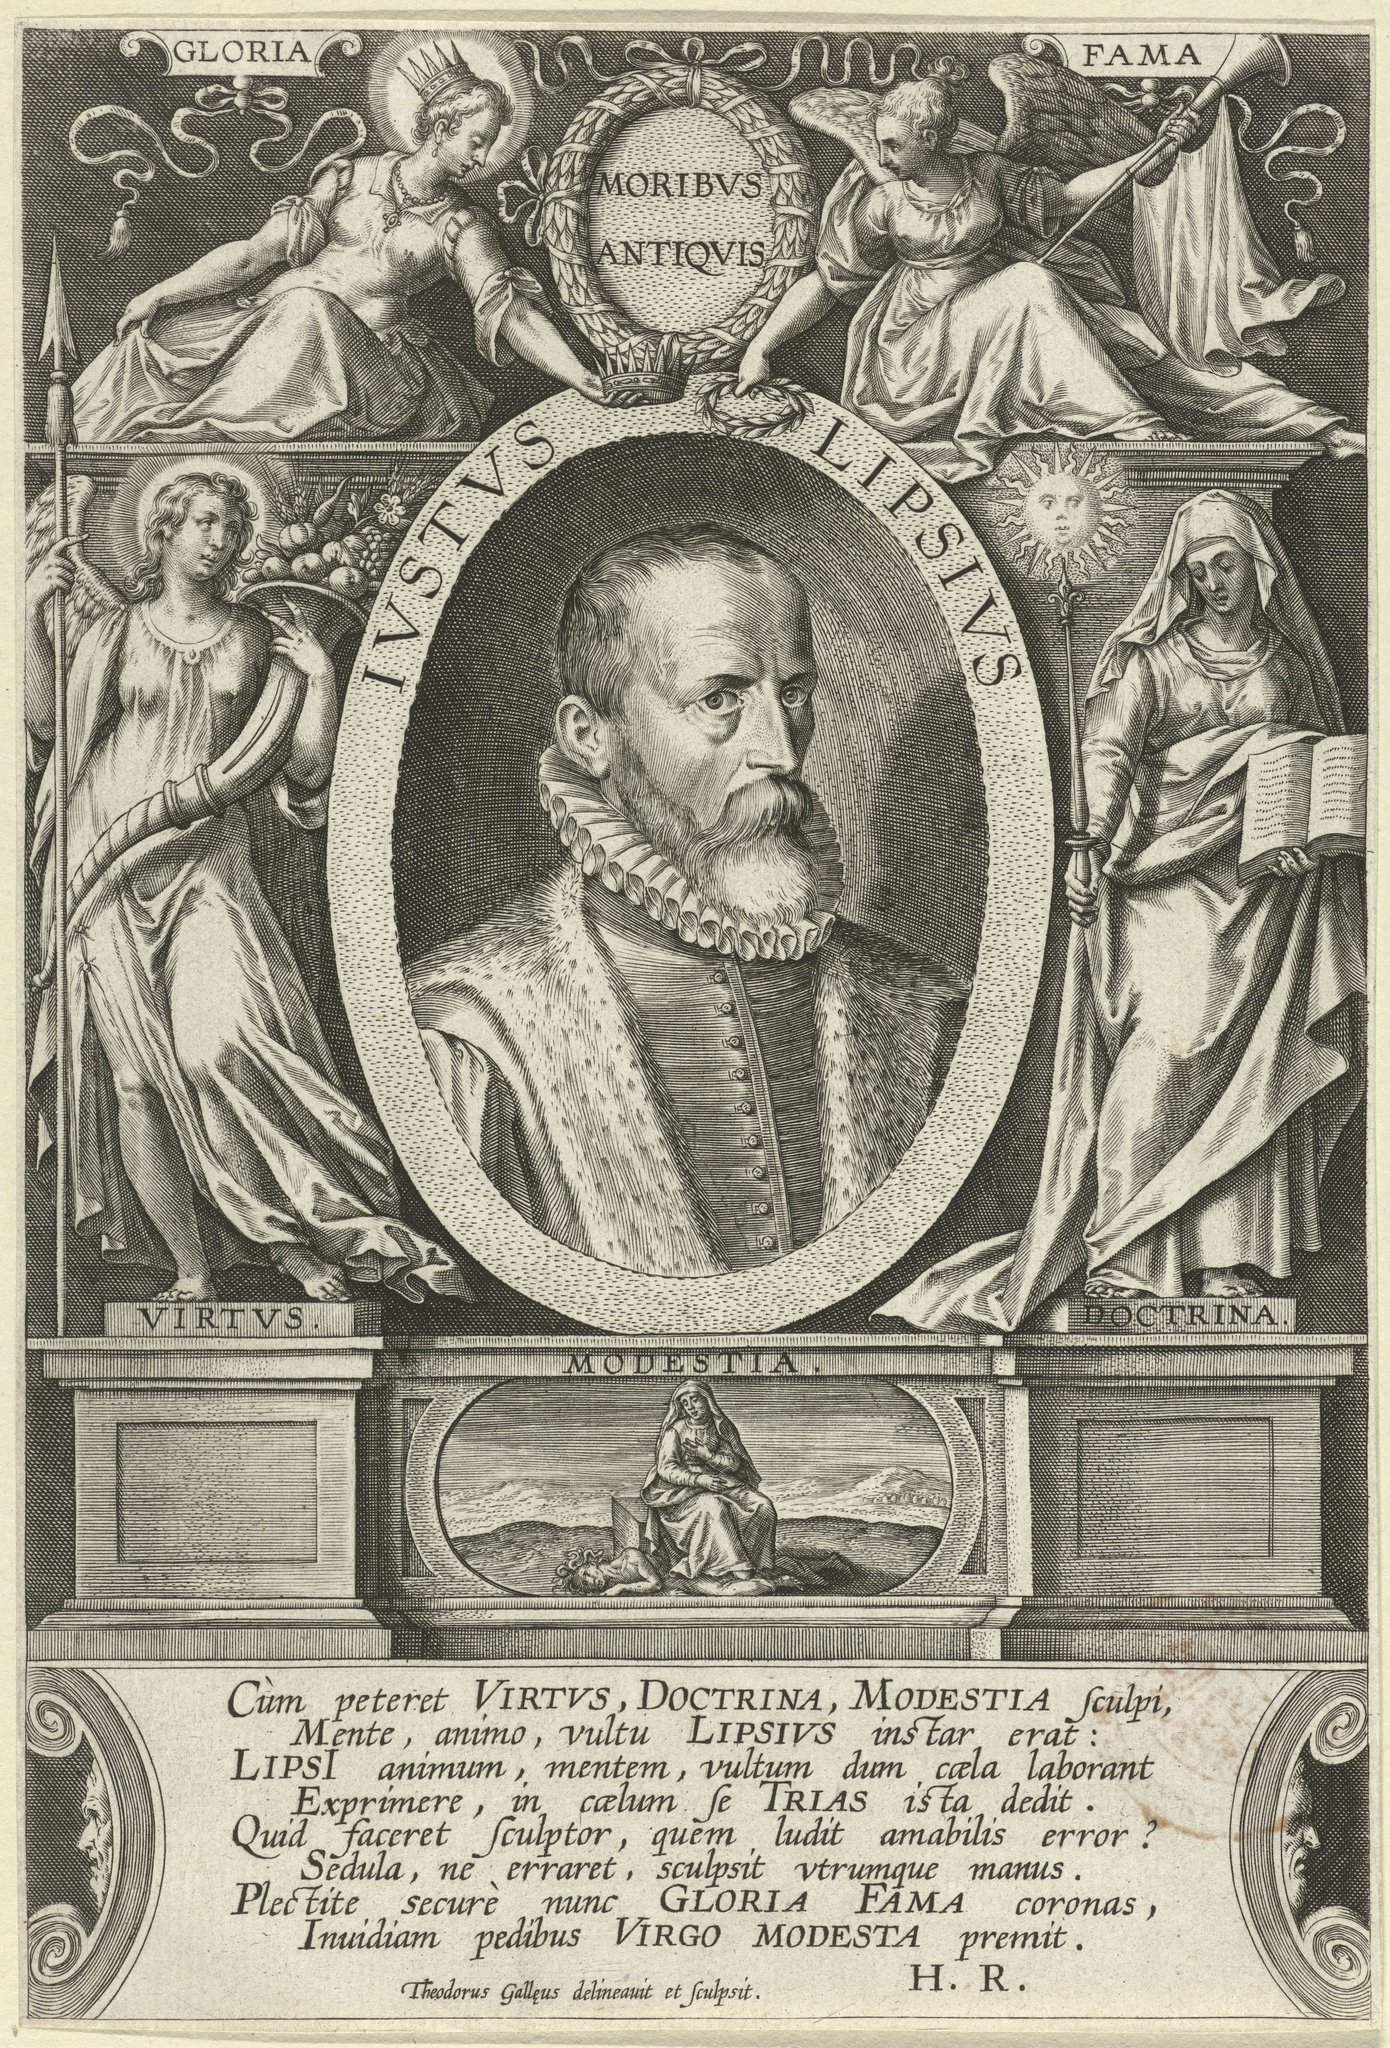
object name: print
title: Ivstvs Lipsivs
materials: paper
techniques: engraving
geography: antwerp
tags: louvain, justus lipsius, envy; 'invidia' (ripa) ~ personification of one of the seven deadly sins, virtuousness; 'amor di virtù', 'attione virtuosa', 'guida sicura de' veri honori', 'virtù', 'virtù insuperabile' (ripa), fame; 'fama', 'fama buona', 'fama chiara' (ripa), honour, glory; 'ampiezza della gloria', 'gloria', 'gloria de prencipi', 'gloria & honore', 'honore', 'sublimatà della gloria' (ripa), discretion, modesty; 'discretione', 'modestia' (ripa), doctrine (+ personification)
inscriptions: collector's mark: Lugt 240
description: Portret in een ovale lijst van de humanist en geleerde Justus Lipsius. Buste naar rechts. Aan weerszijden van het portret de personificaties Deugd (Virtus) en Leer (Doctrina). Boven het portret de personificaties Heerlijkheid (Gloria) en Roem (Fama). Onder het portret de personificatie Bescheidenheid (Modesta), die Nijd (Invidia) vertrapt. De prent heeft een Latijns onderschrift.